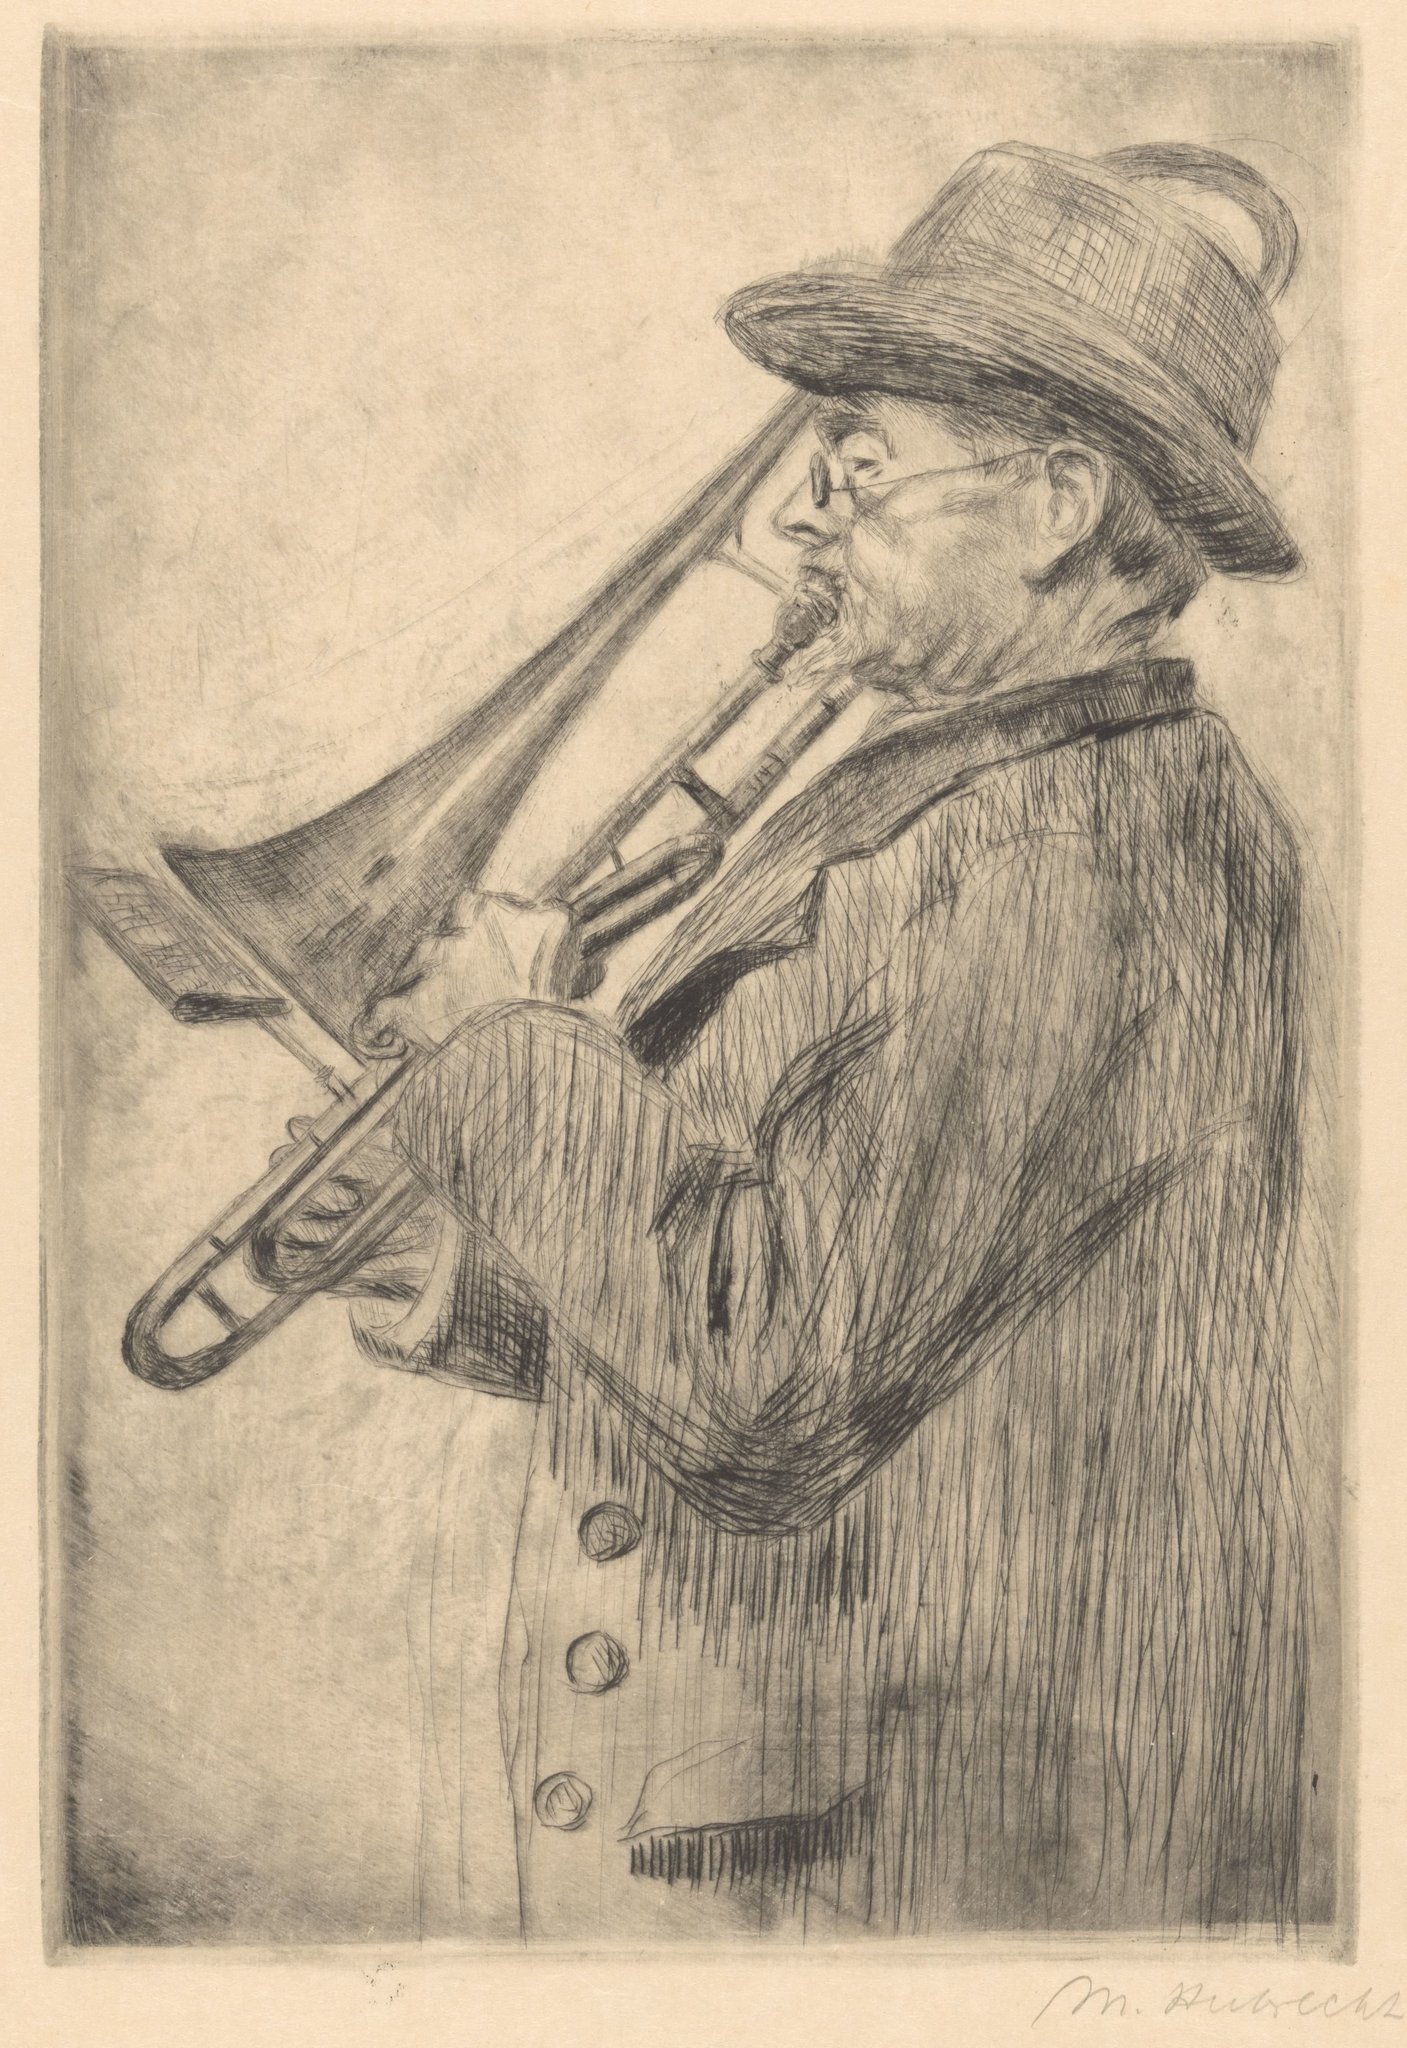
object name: print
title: Trombonist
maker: maria hubrecht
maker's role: print maker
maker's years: 1865-1950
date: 1875-1950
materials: paper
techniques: etching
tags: horn, trumpet, cornet, trombone, tuba, one person playing wind instrument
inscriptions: collector's mark: Lugt 2228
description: Een man met een hoed en een bril speelt trombone.